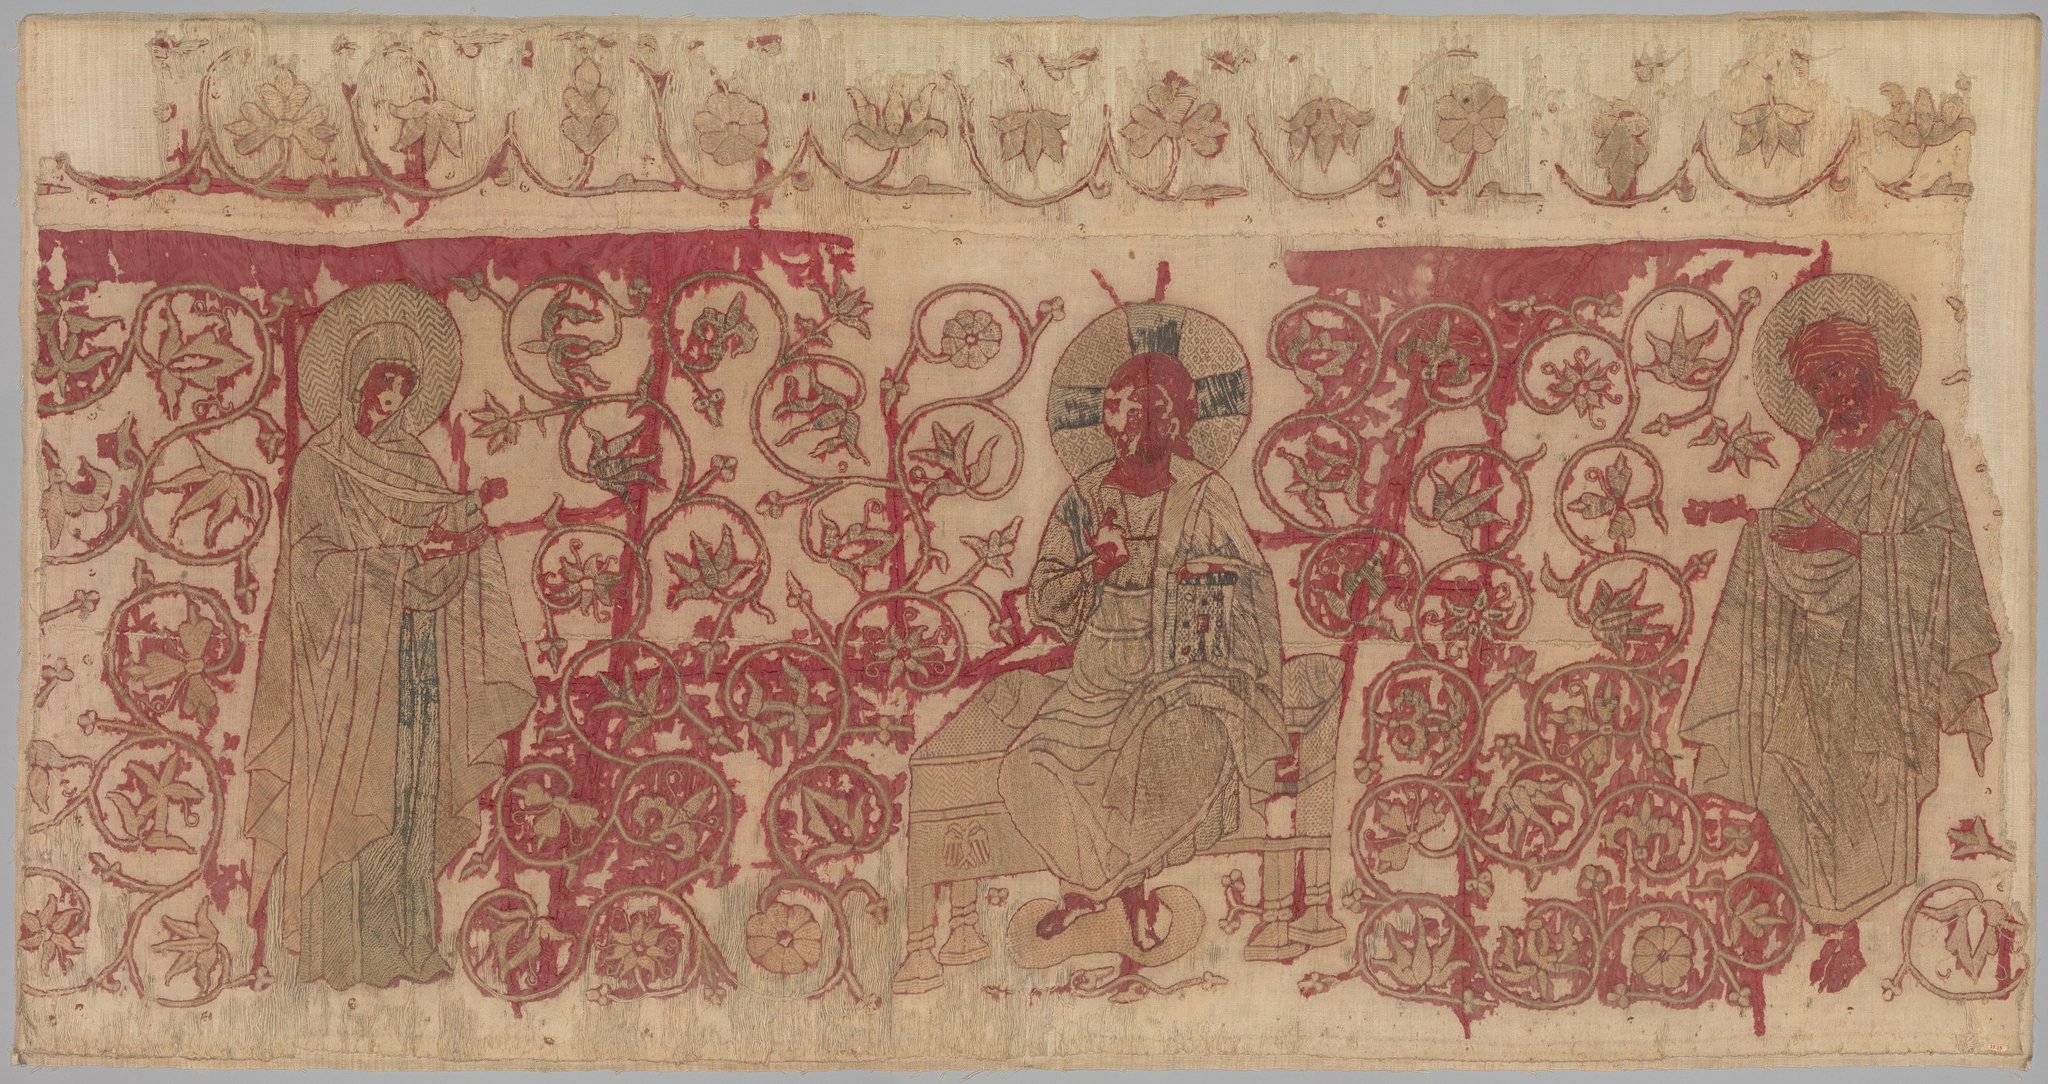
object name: textile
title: Altar Frontal with Deesis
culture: eastern european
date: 1401-1500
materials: metal thread, silk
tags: christ,saint john the baptist,virgin mary